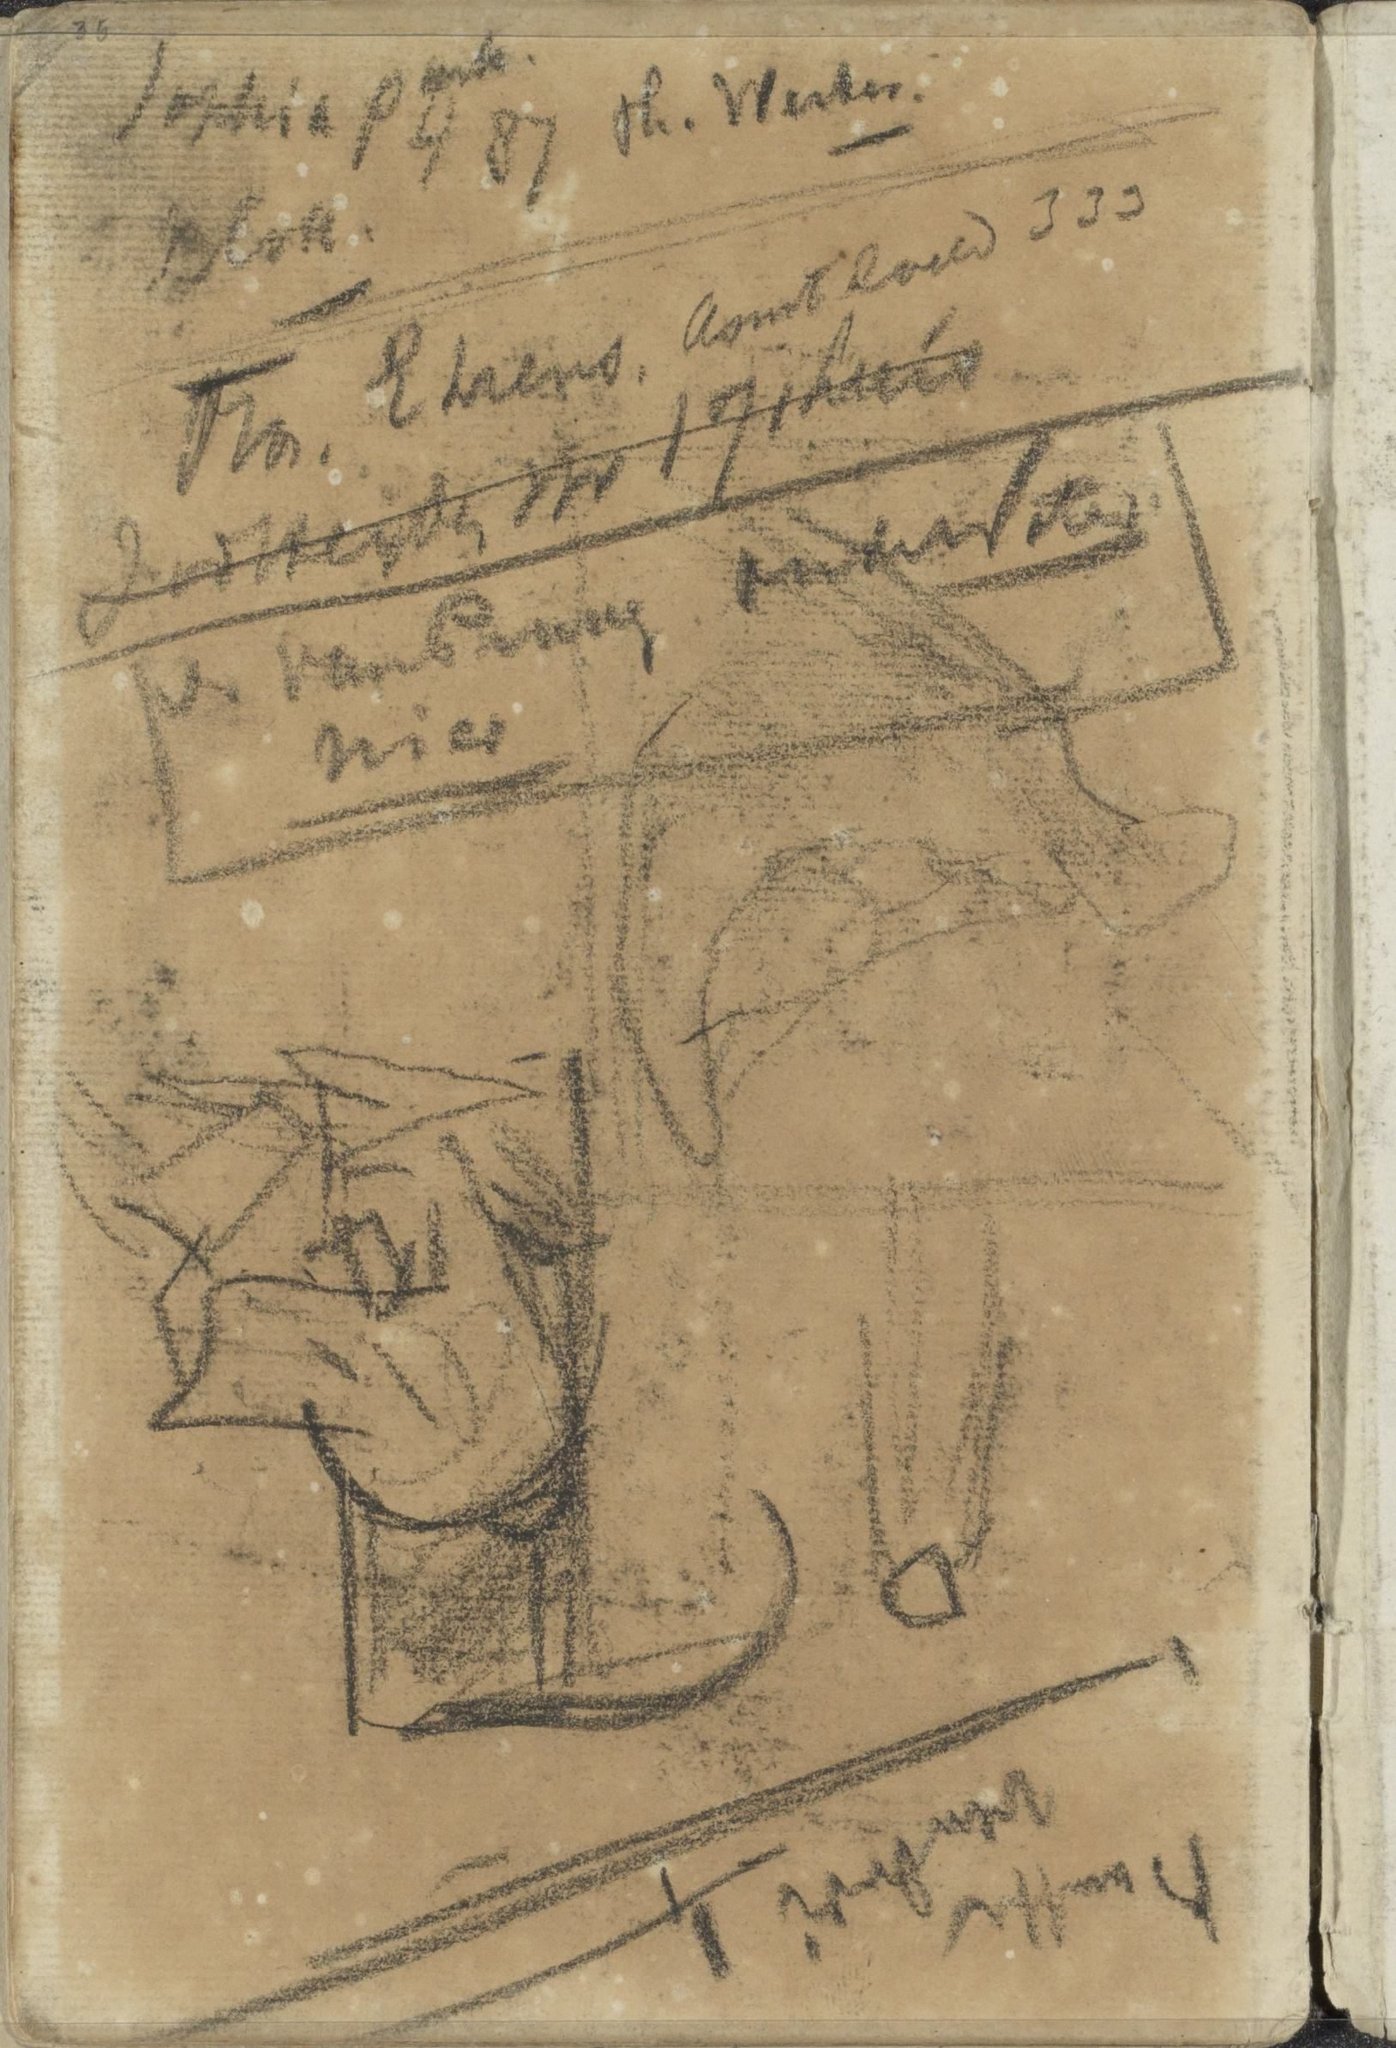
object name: sketchbook leaf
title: Figuurstudies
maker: george hendrik breitner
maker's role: draughtsman, painter, print maker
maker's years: 1857-1923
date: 1887-1891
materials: chalk, paper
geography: amsterdam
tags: adult woman, adult man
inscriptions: annotation: ‘[...]/ Sophiapark/ Blok 487 Th. Werker/ [...]’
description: Pagina 35 uit een schetsboek met 17 bladen.